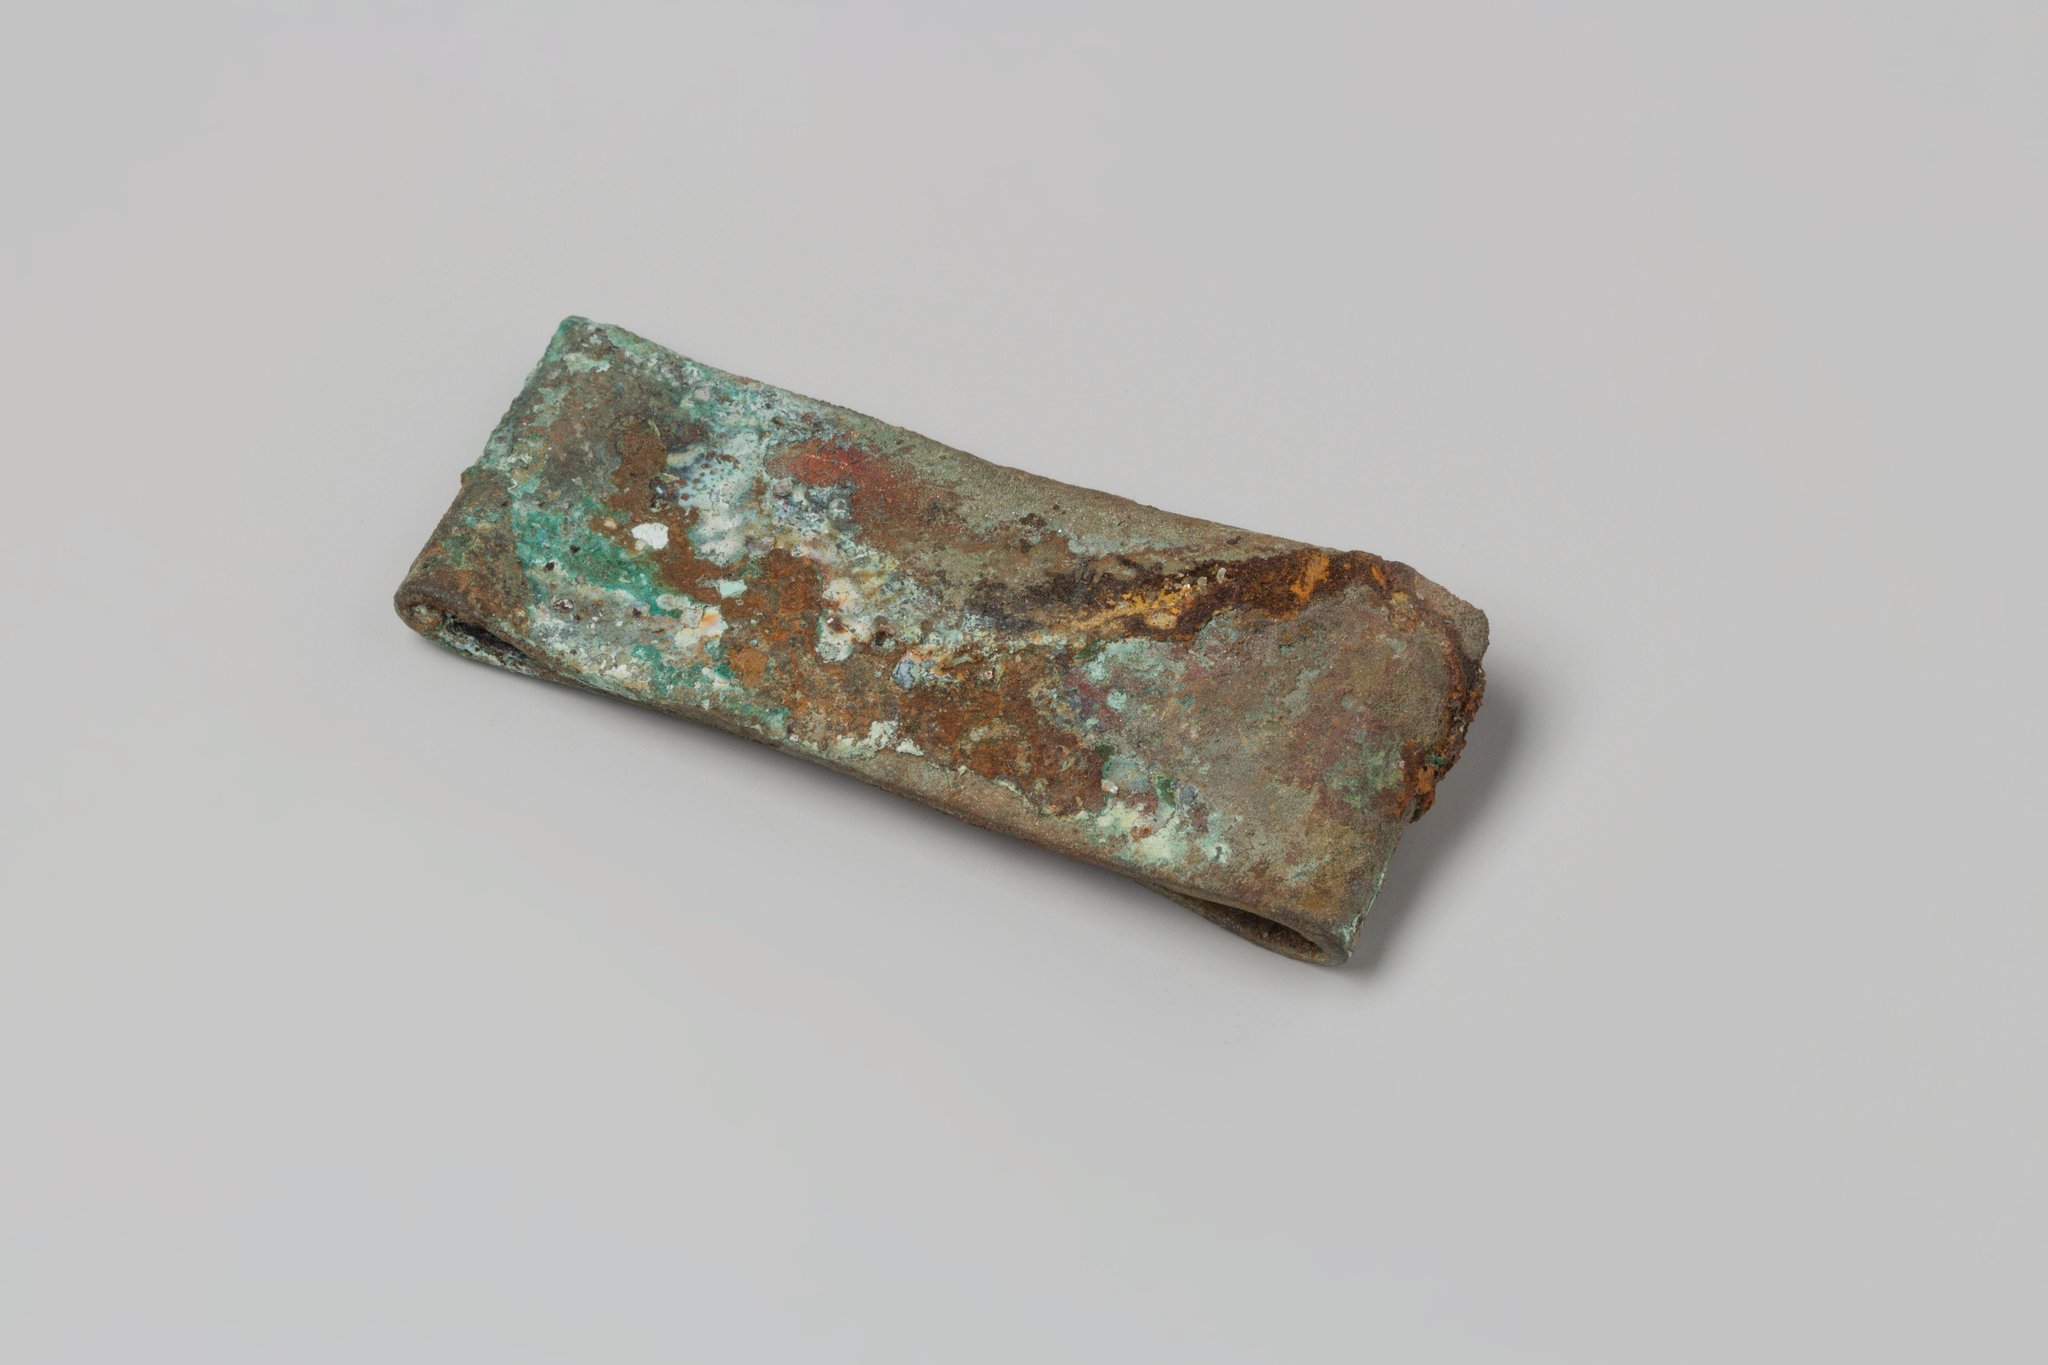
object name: firehose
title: Fragment van brandslangring uit het wrak van de Oost-Indiëvaarder Hollandia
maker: Anonymous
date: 1700-1743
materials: copper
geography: netherlands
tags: verenigde oostindische compagnie, hollandia (schip), annet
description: Fire engine, firehose; fragments, id. NG-1975-20-H-1271-a, squashed corroded.